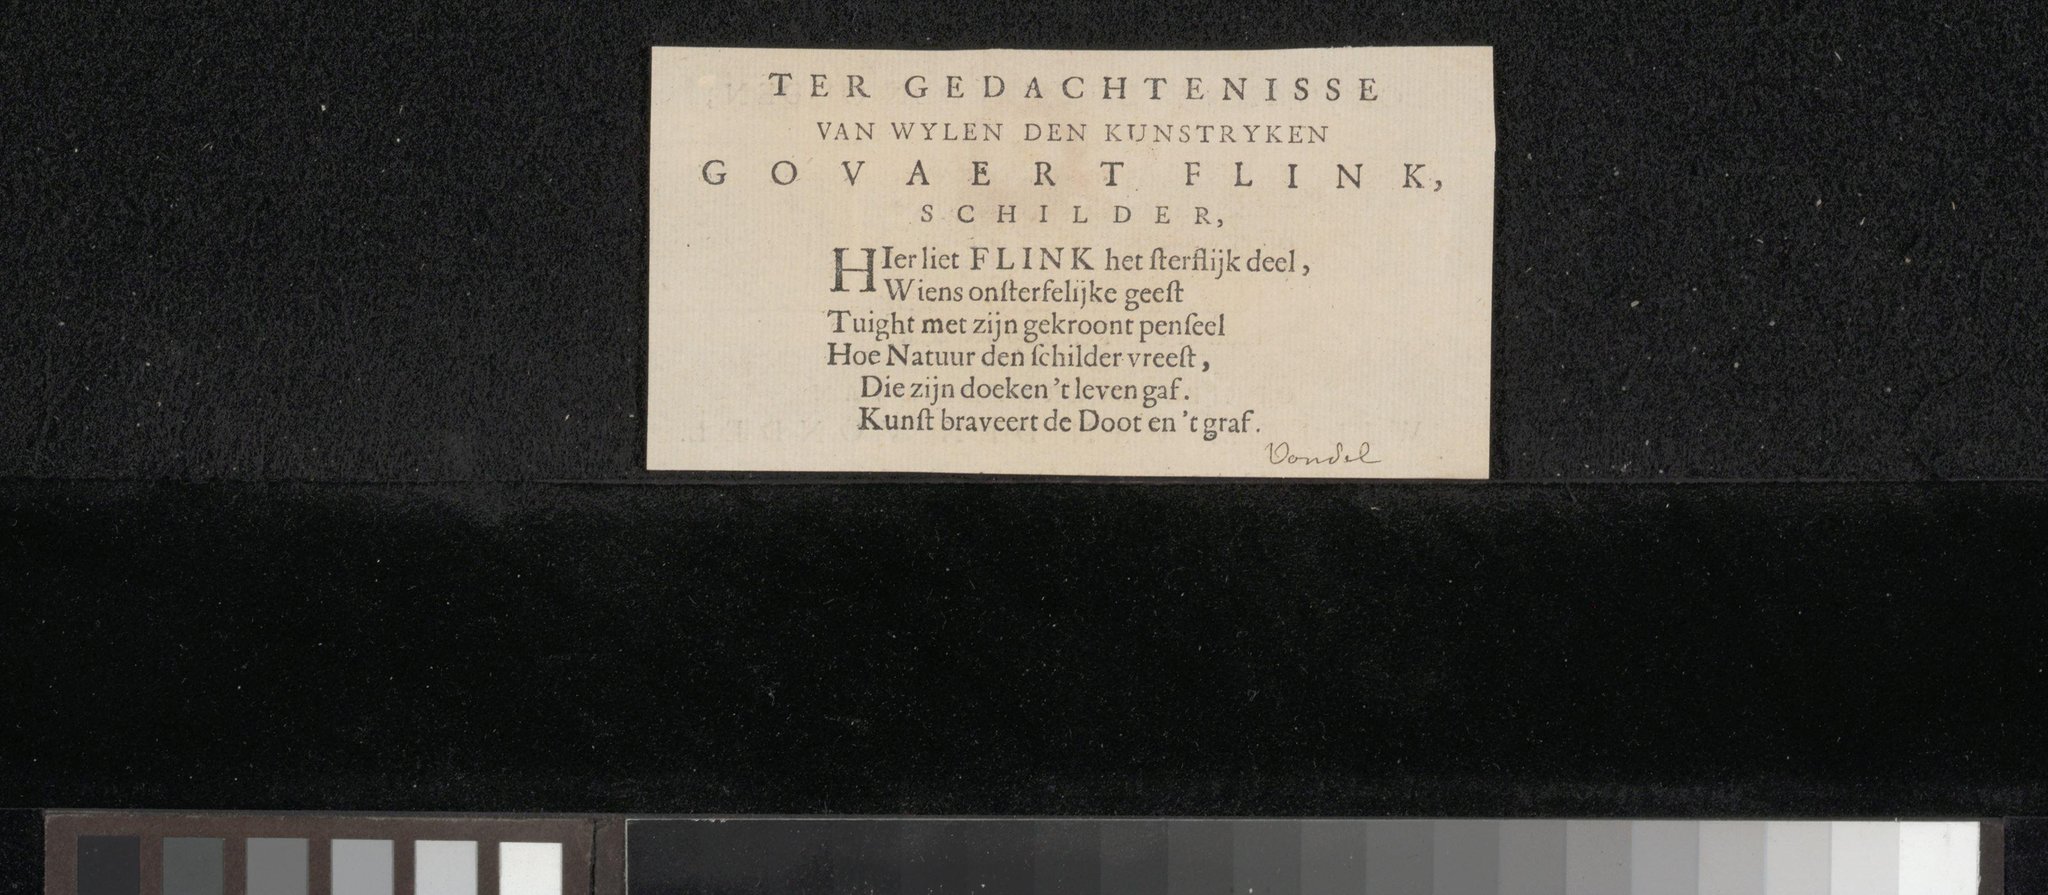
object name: poem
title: Rouwgedicht op Govert Flinck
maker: joost van den vondel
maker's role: dichter, toneelschrijver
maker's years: 1587-1679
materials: ink, paper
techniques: pen, printing, writing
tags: cleves, amsterdam, draughtsman, govert flinck, print maker, johannes lutma (1624-1689), painting (including book-illumination, miniature-painting)